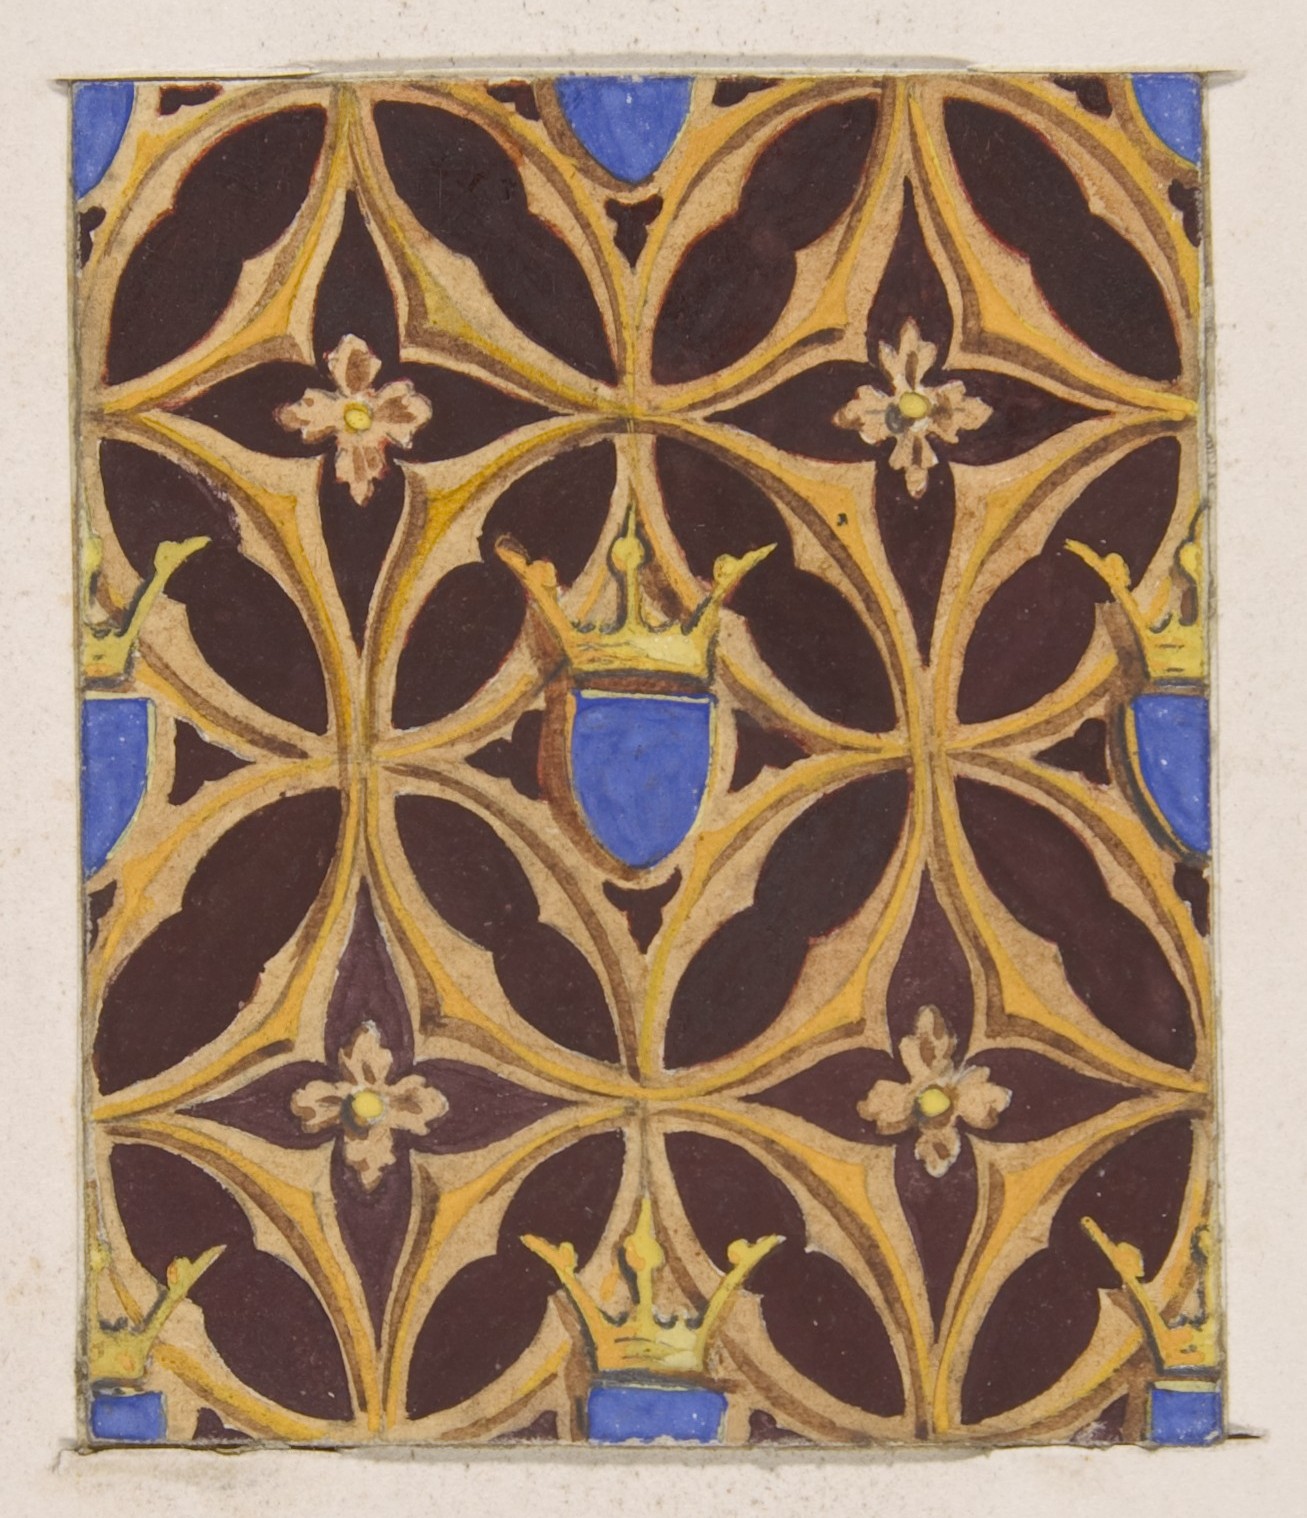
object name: drawing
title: Design for wallpaper featuring blue shields surmouted by crowns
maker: jules-edmond-charles lachaise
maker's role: artist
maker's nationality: french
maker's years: 1897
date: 1830-1897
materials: gouache, graphite, paper